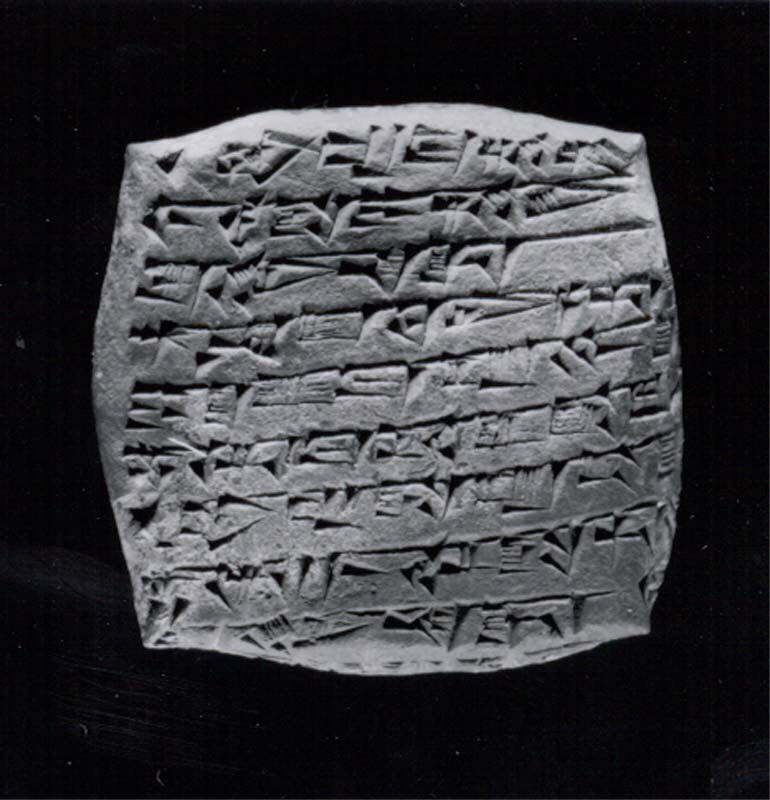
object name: cuneiform tablet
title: Cuneiform tablet: quittance for a loan in copper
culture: assyrian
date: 2000-1801 BCE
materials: clay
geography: anatolia